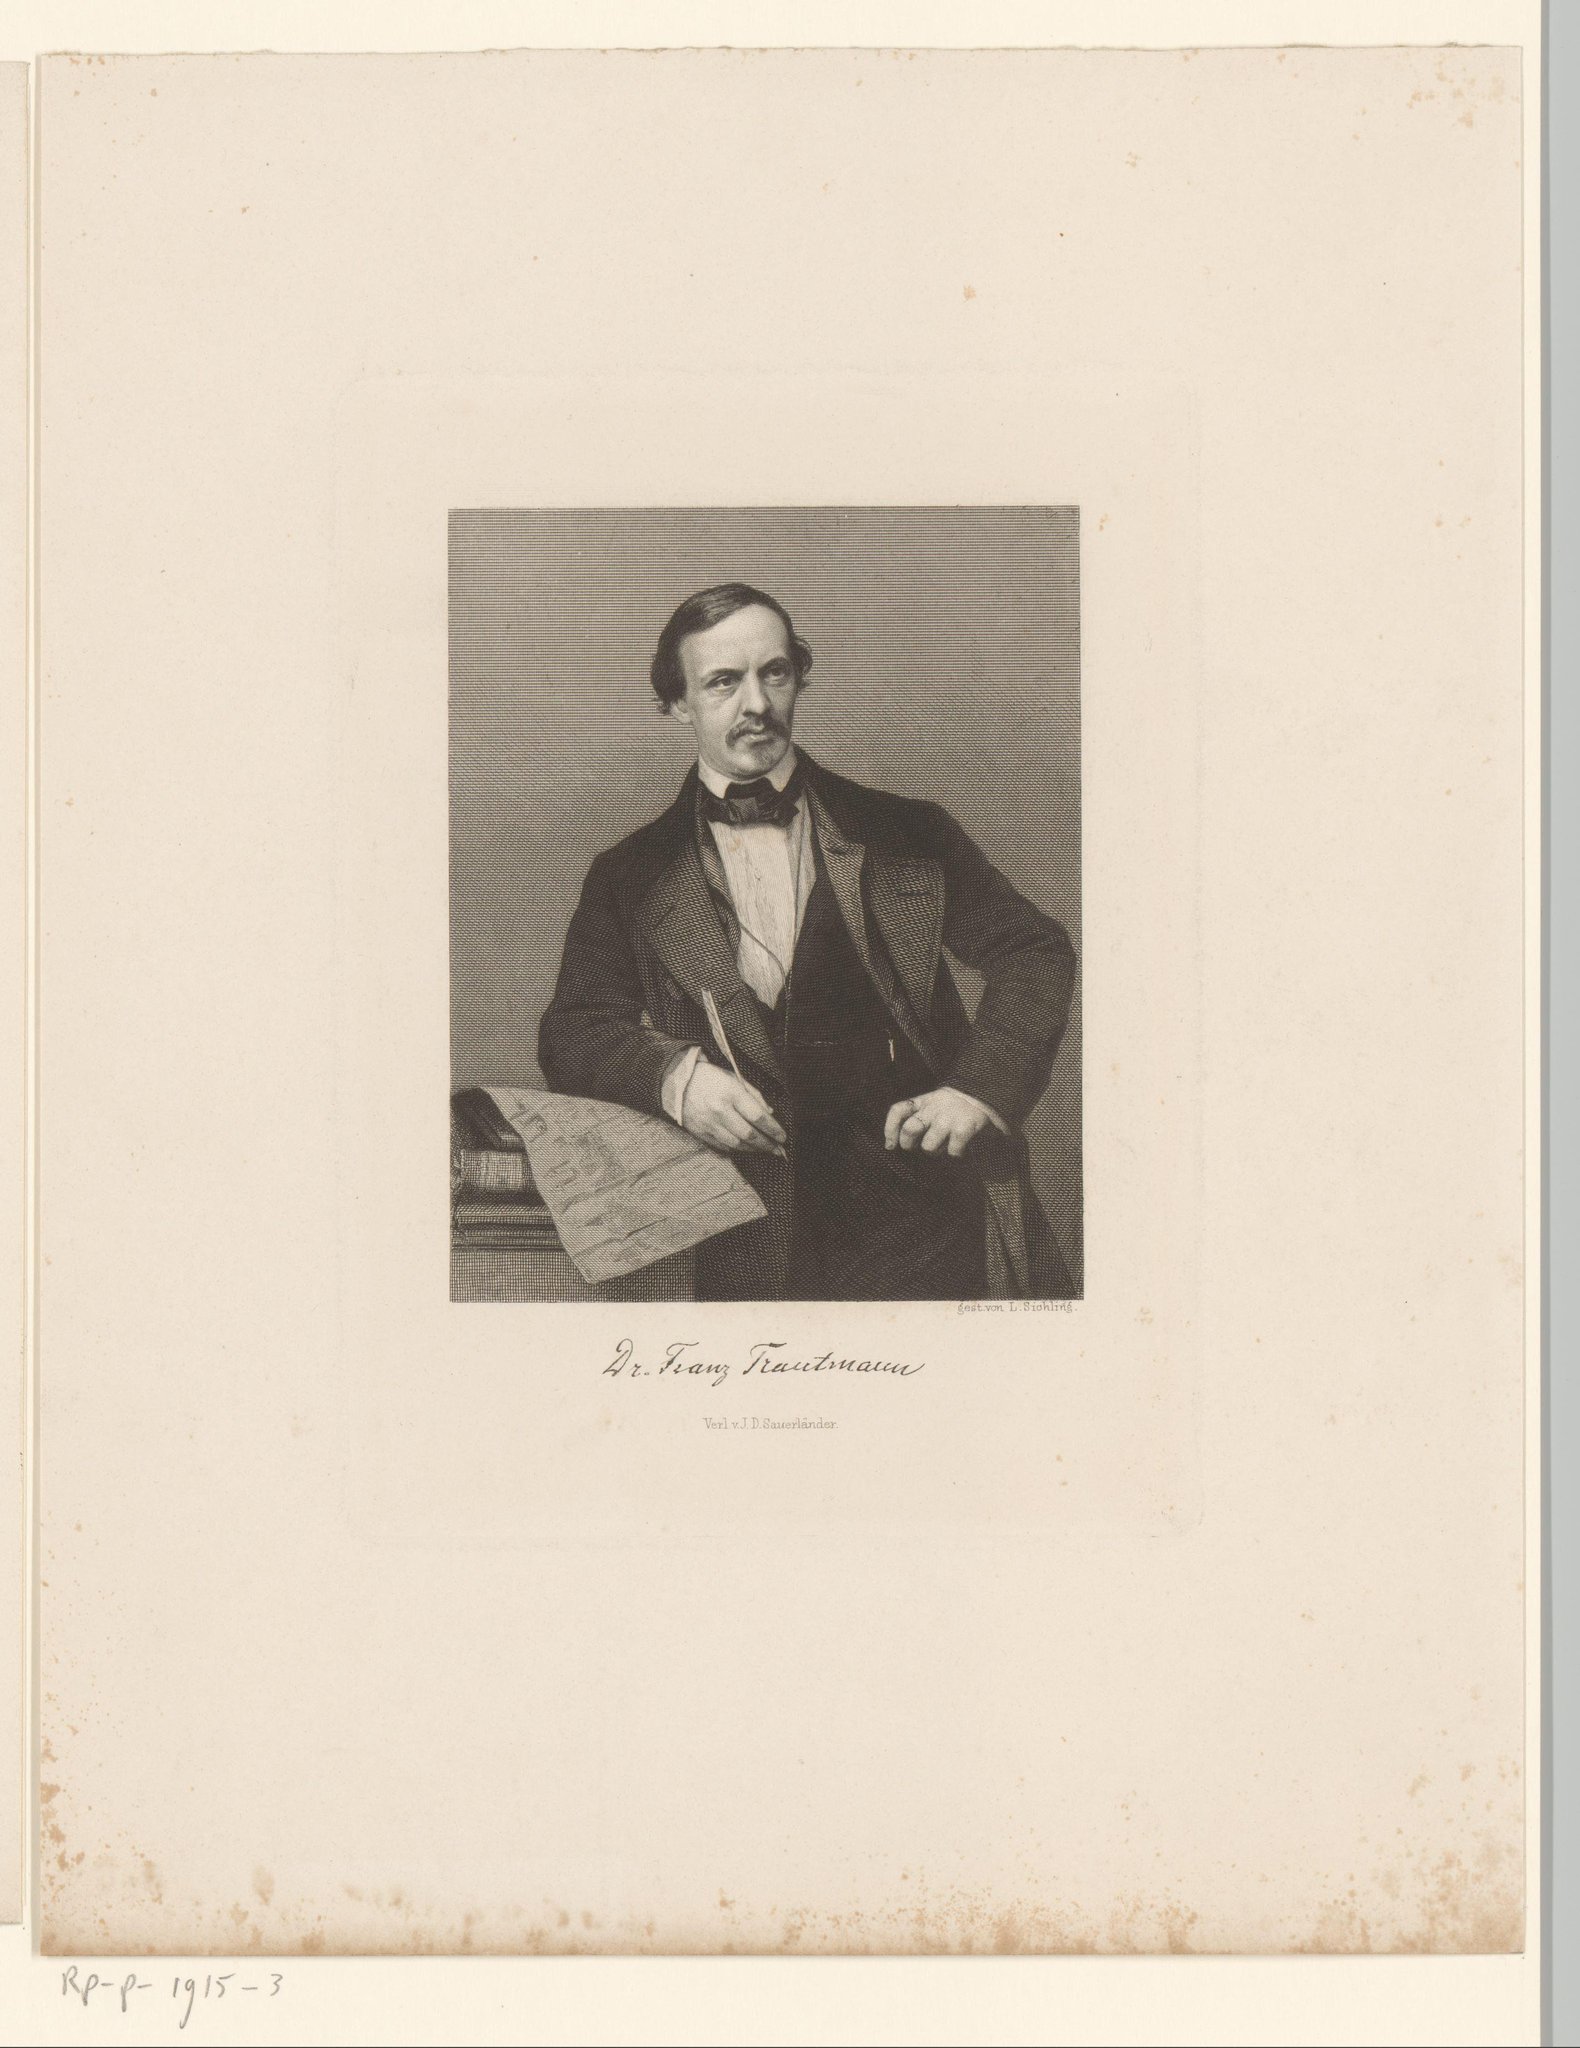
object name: print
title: Portret van Franz Trautmann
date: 1827-1863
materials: paper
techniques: engraving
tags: historical persons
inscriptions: collector's mark: Lugt 2228